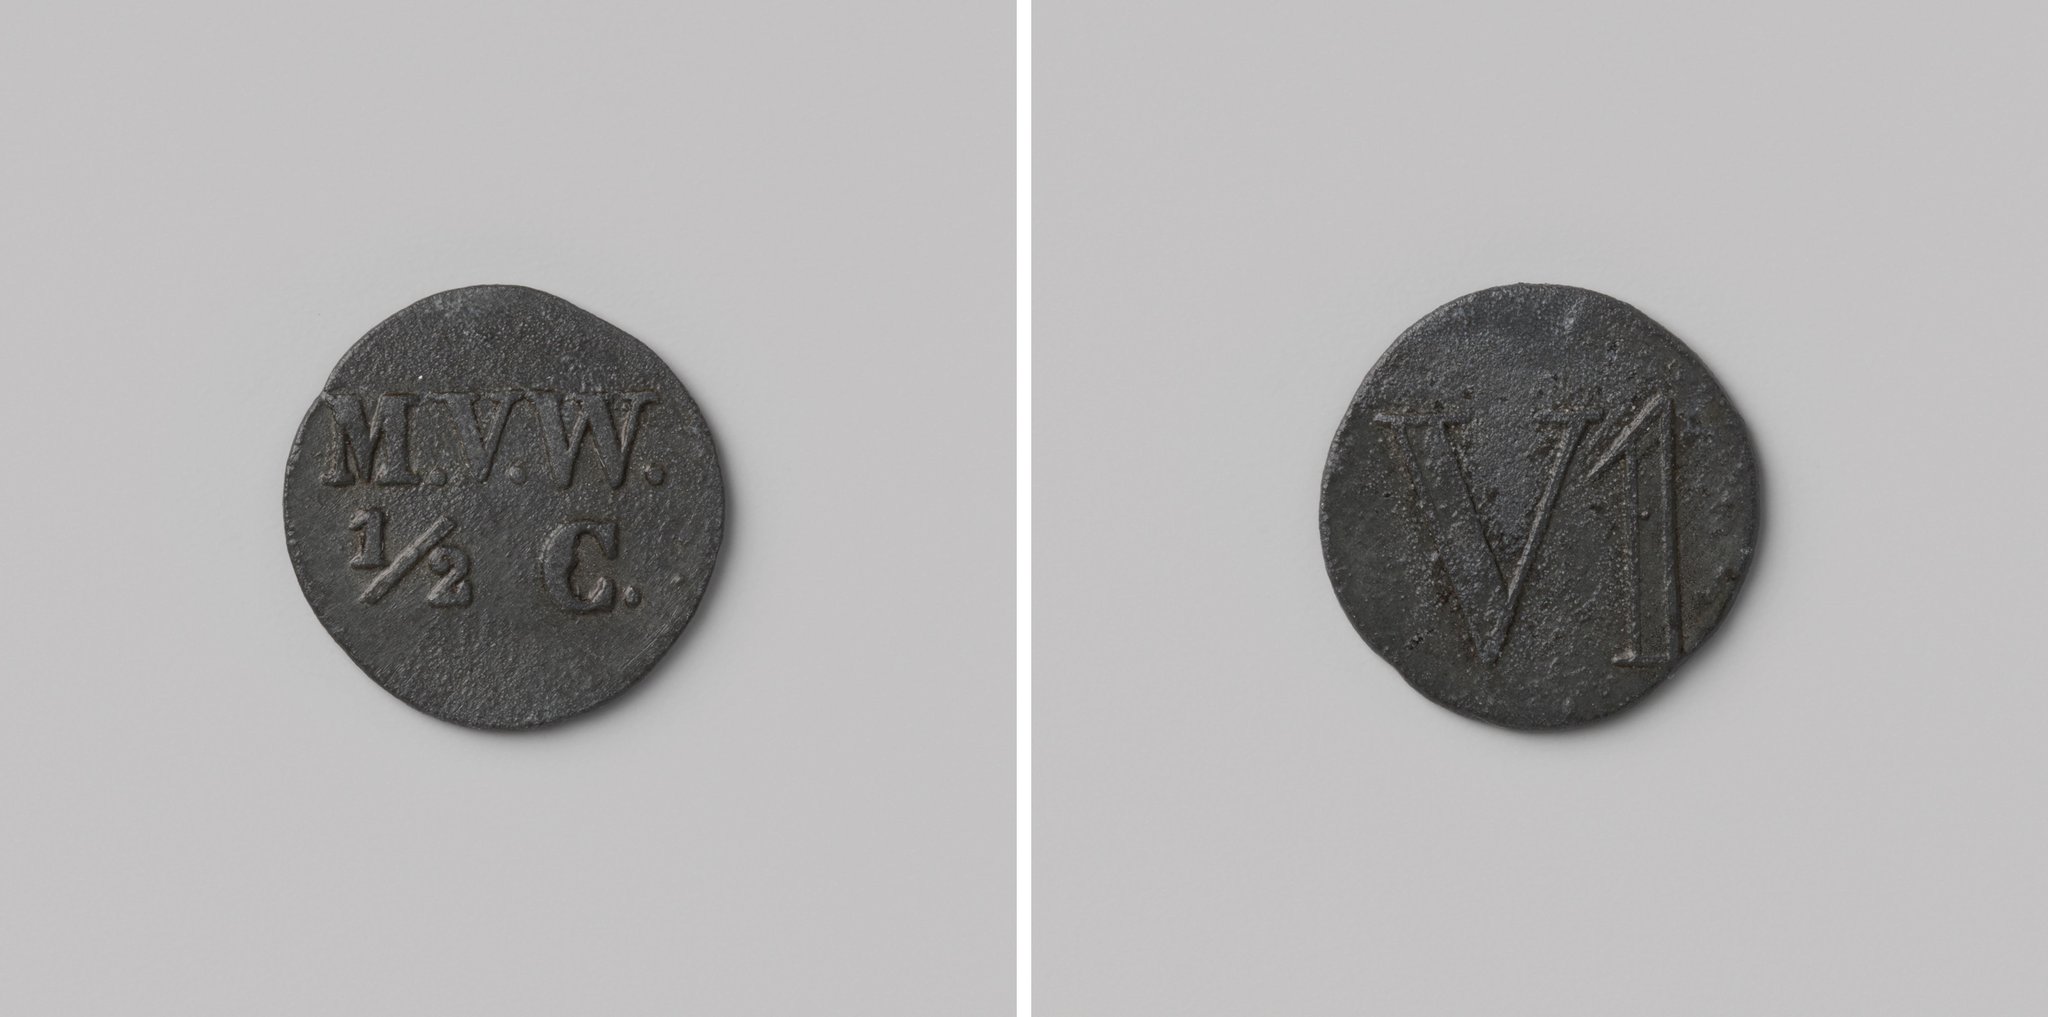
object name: huismunt prison money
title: Eerste gesticht van de strafkolonie Veenhuizen, huismunt geslagen op last van de Maatschappij van Weldadigheid ter waarde van ½ cent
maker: Anonymous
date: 1818-1859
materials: zinc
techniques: striking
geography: netherlands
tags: maatschappij van weldadigheid, veenhuizen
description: Zinken munt. Voorzijde: opschrift boven waardeaanduiding. Keerzijde: opschrift V en 1